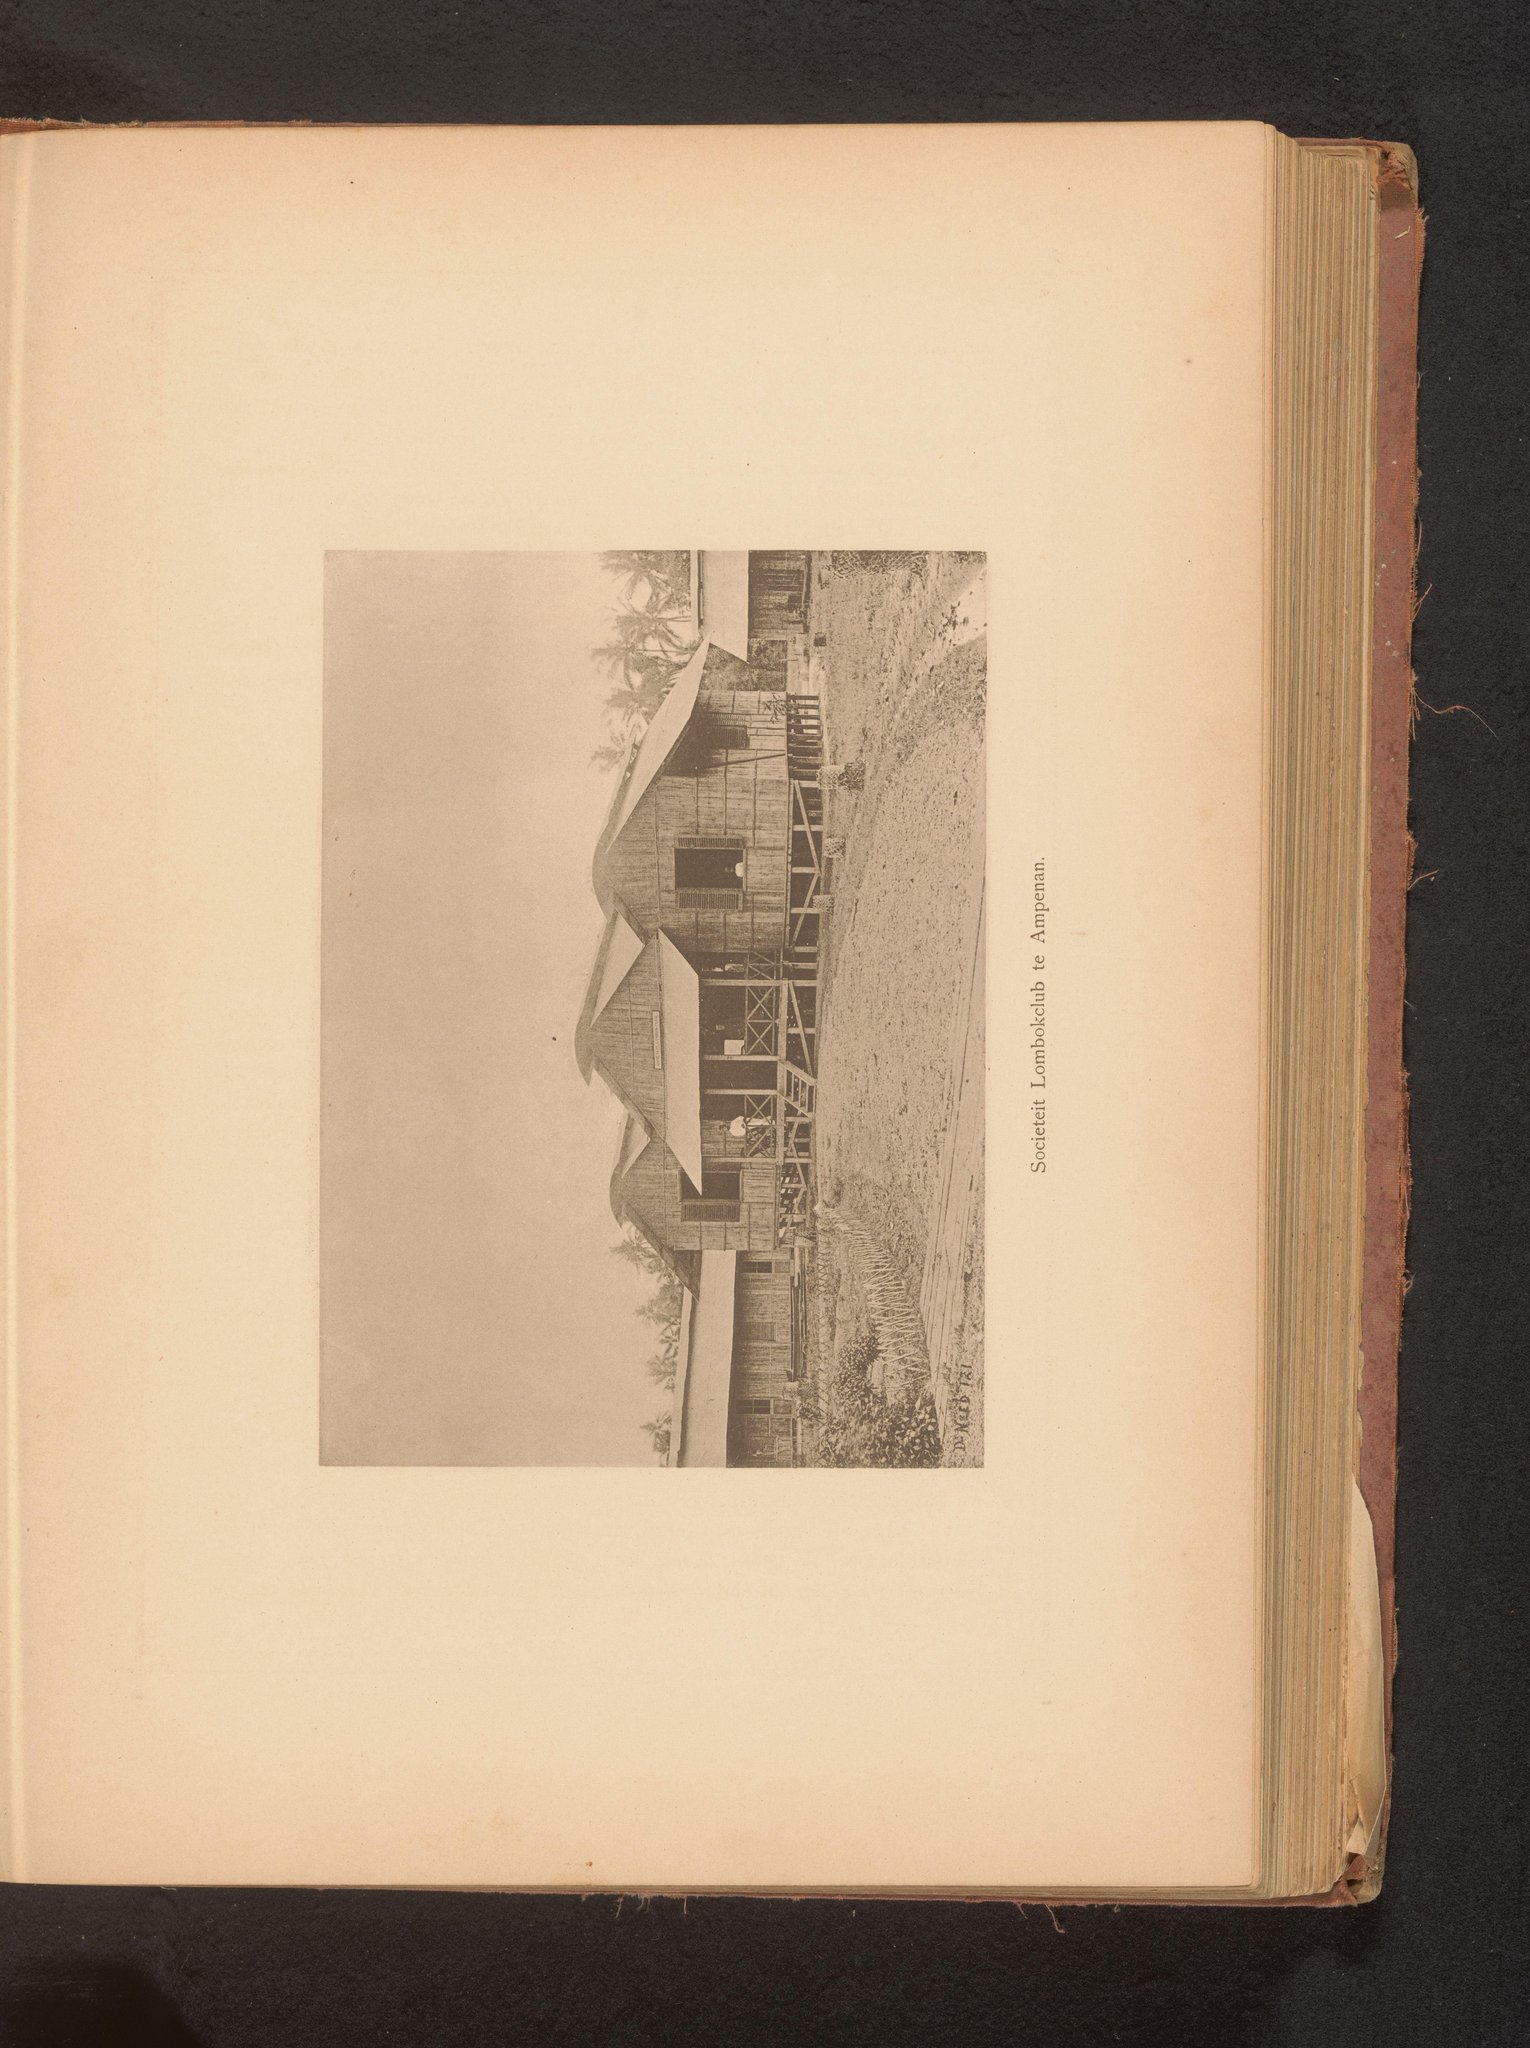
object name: page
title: Societeit Lombokclub te Ampenan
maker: christiaan johan neeb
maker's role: arts, fotograaf, officier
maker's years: 1860-1925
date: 1892-1897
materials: paper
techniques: photograph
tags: other dwelling types